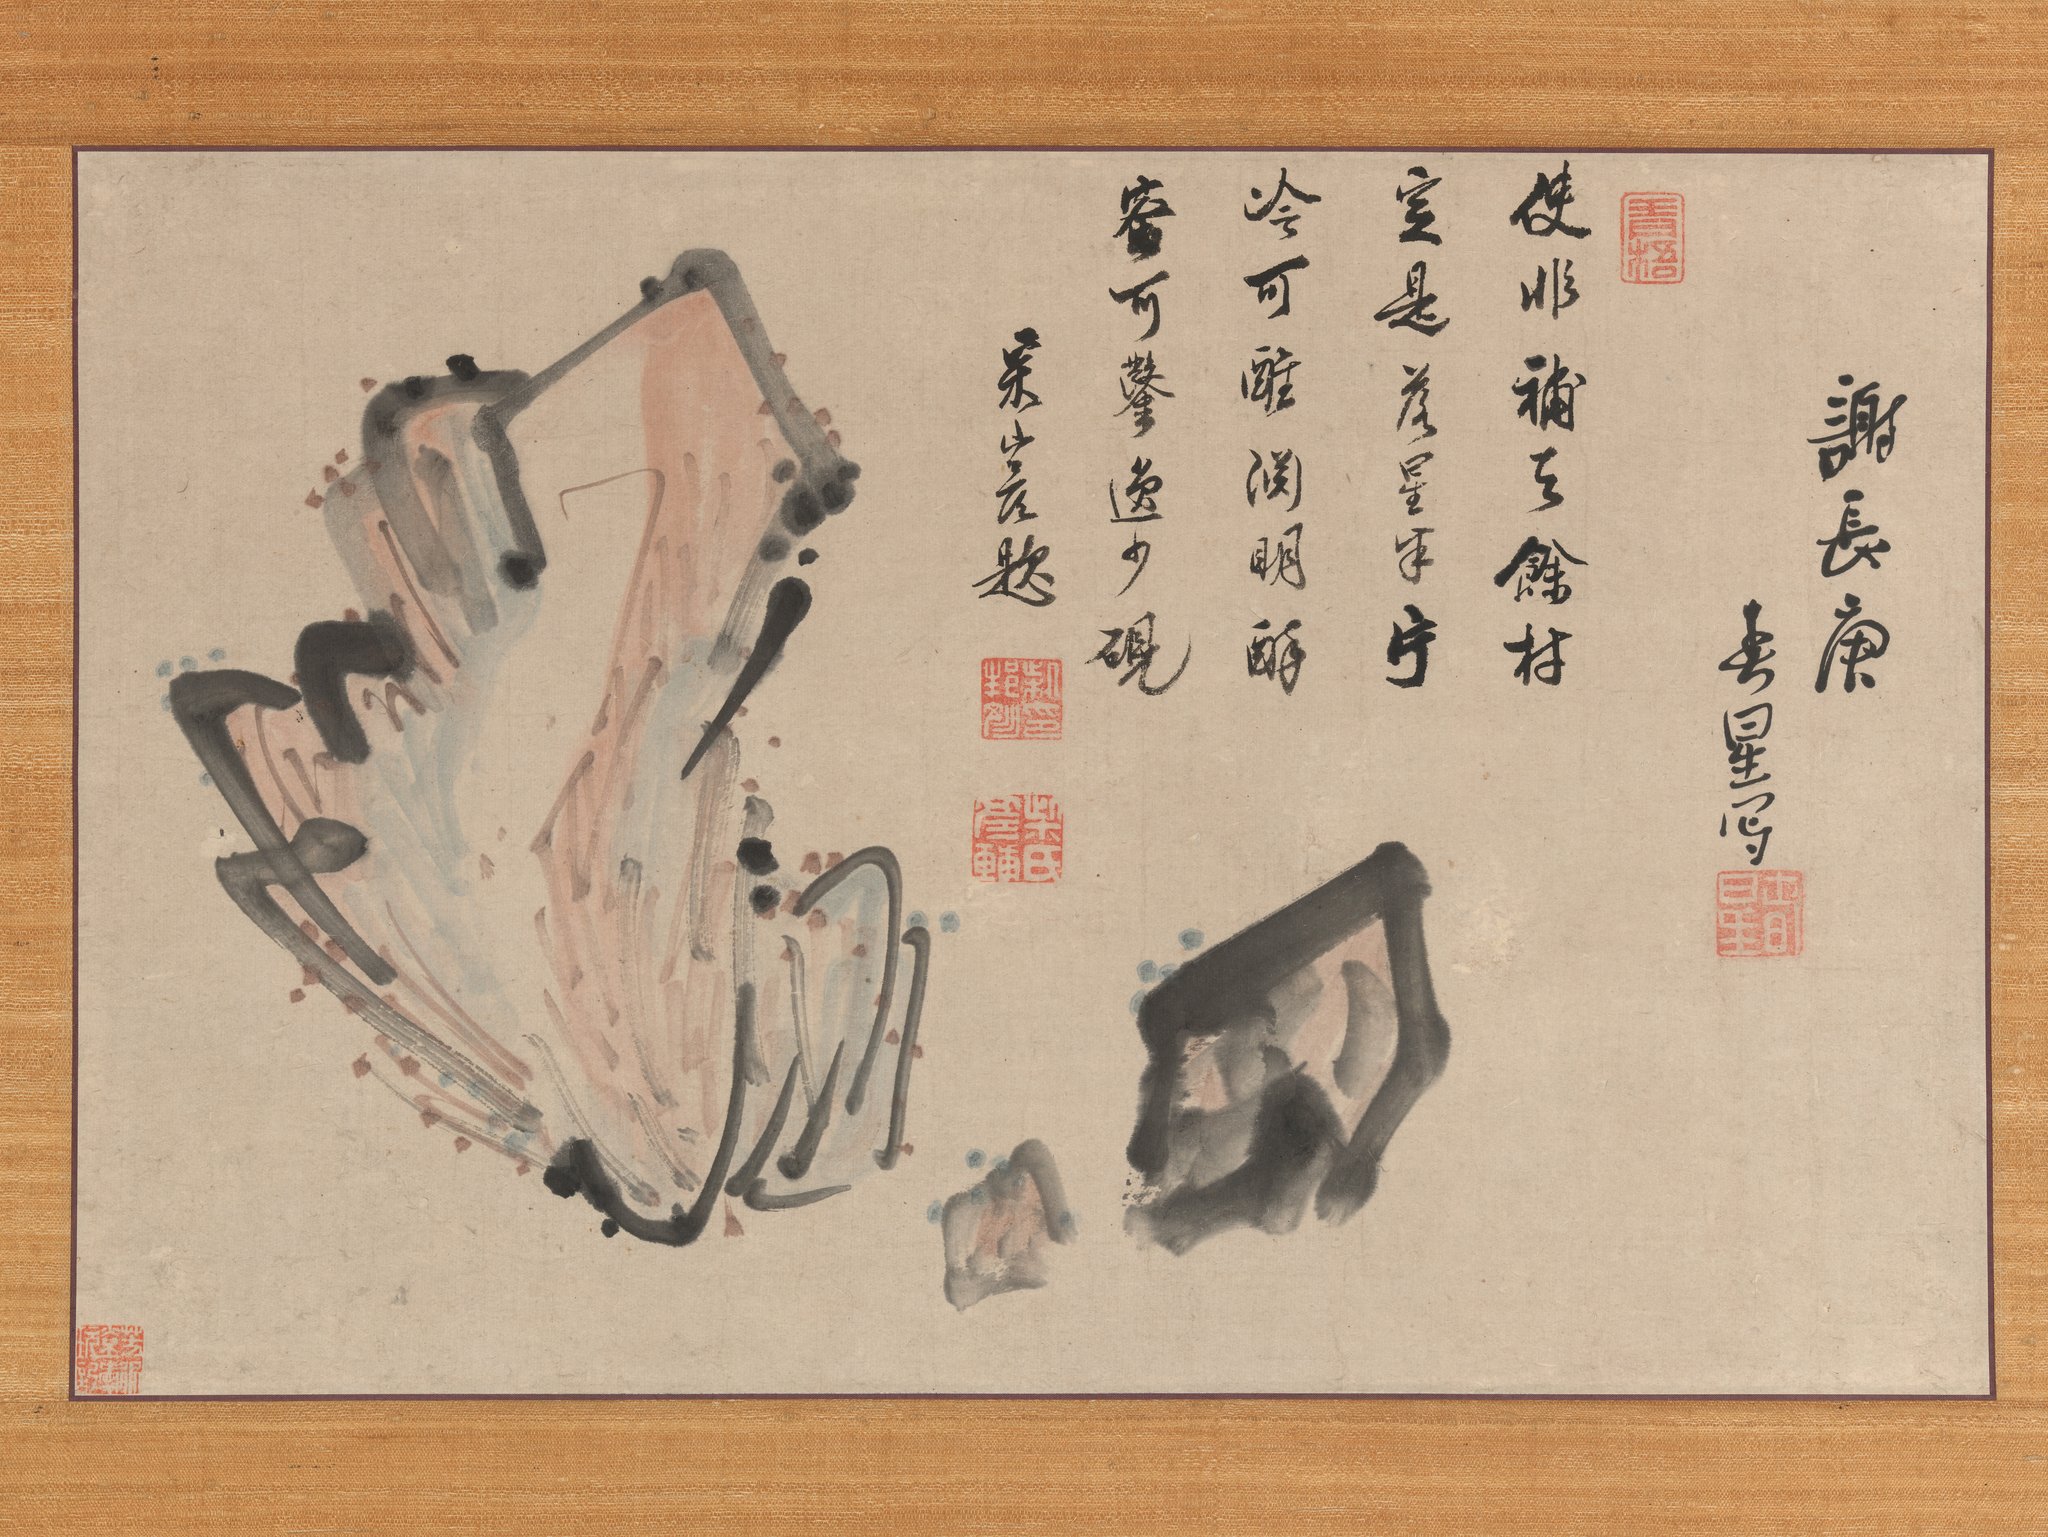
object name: hanging scroll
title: Rocks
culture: japanese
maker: yosa buson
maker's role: artist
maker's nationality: japanese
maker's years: 1716-1783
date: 1767-1800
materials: ink, paper